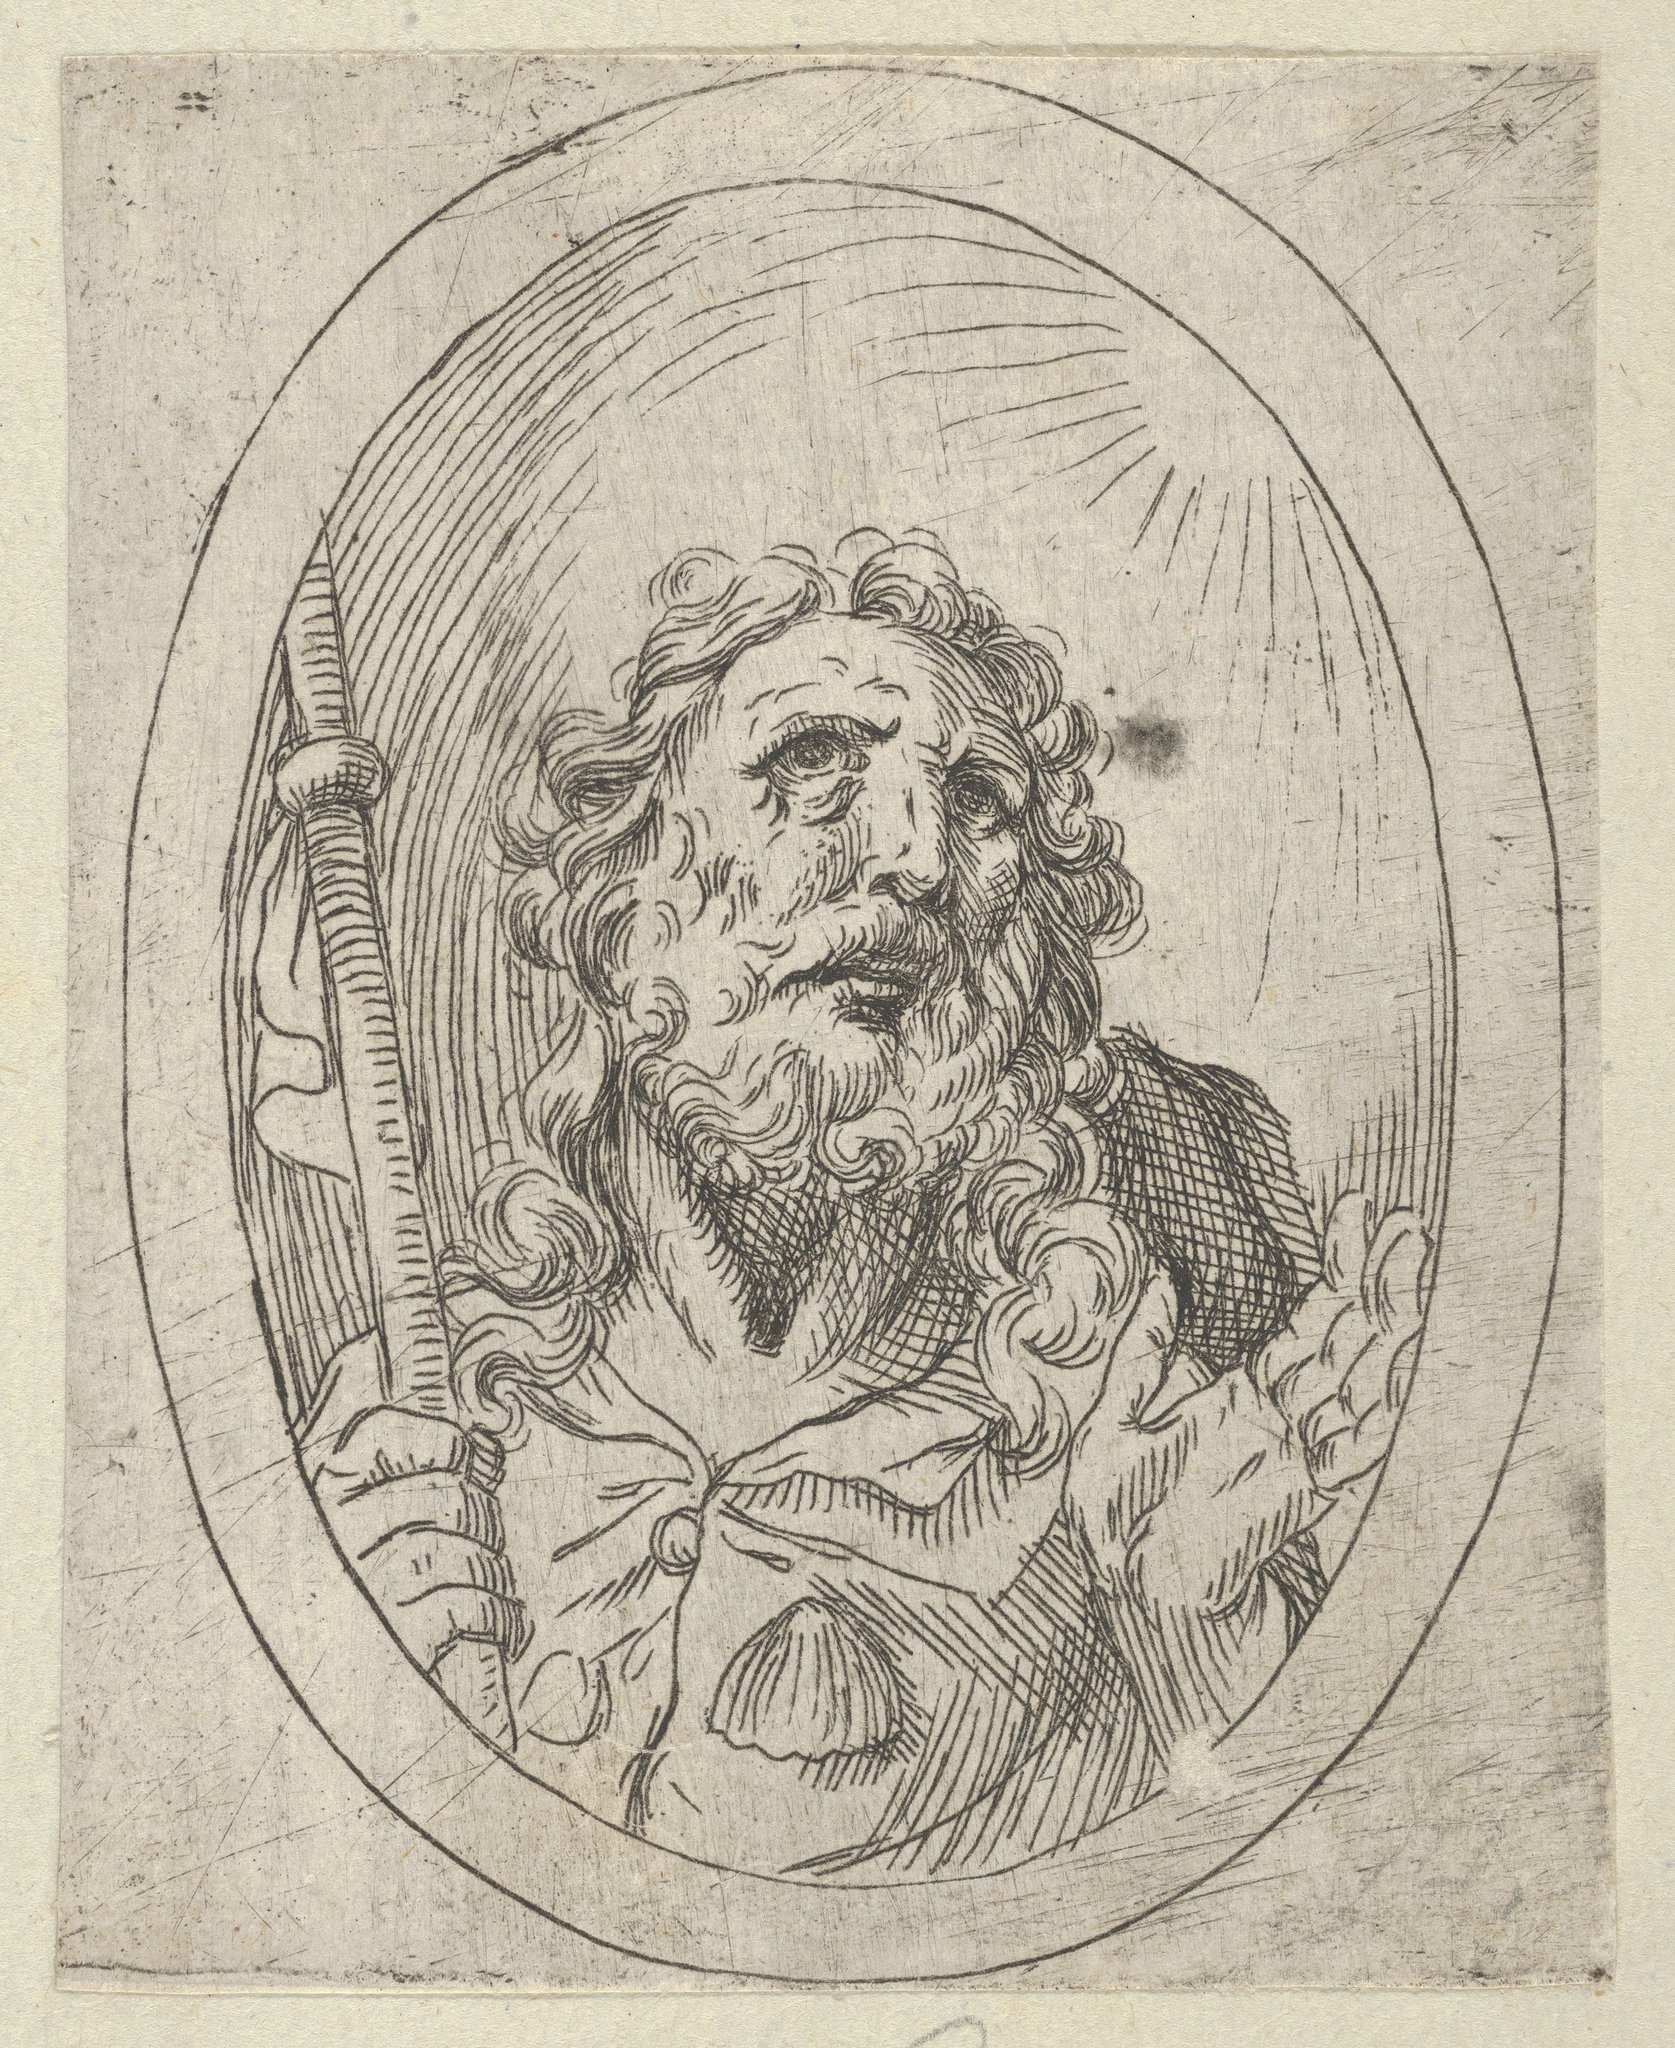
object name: print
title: Saint James Major, looking upwards and holding a staff, from "Christ, the Virgin, and Thirteen Apostles"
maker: anonymous, 17th century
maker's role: artist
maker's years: 1600-1700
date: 1600-1640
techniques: etching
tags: apostles,saints